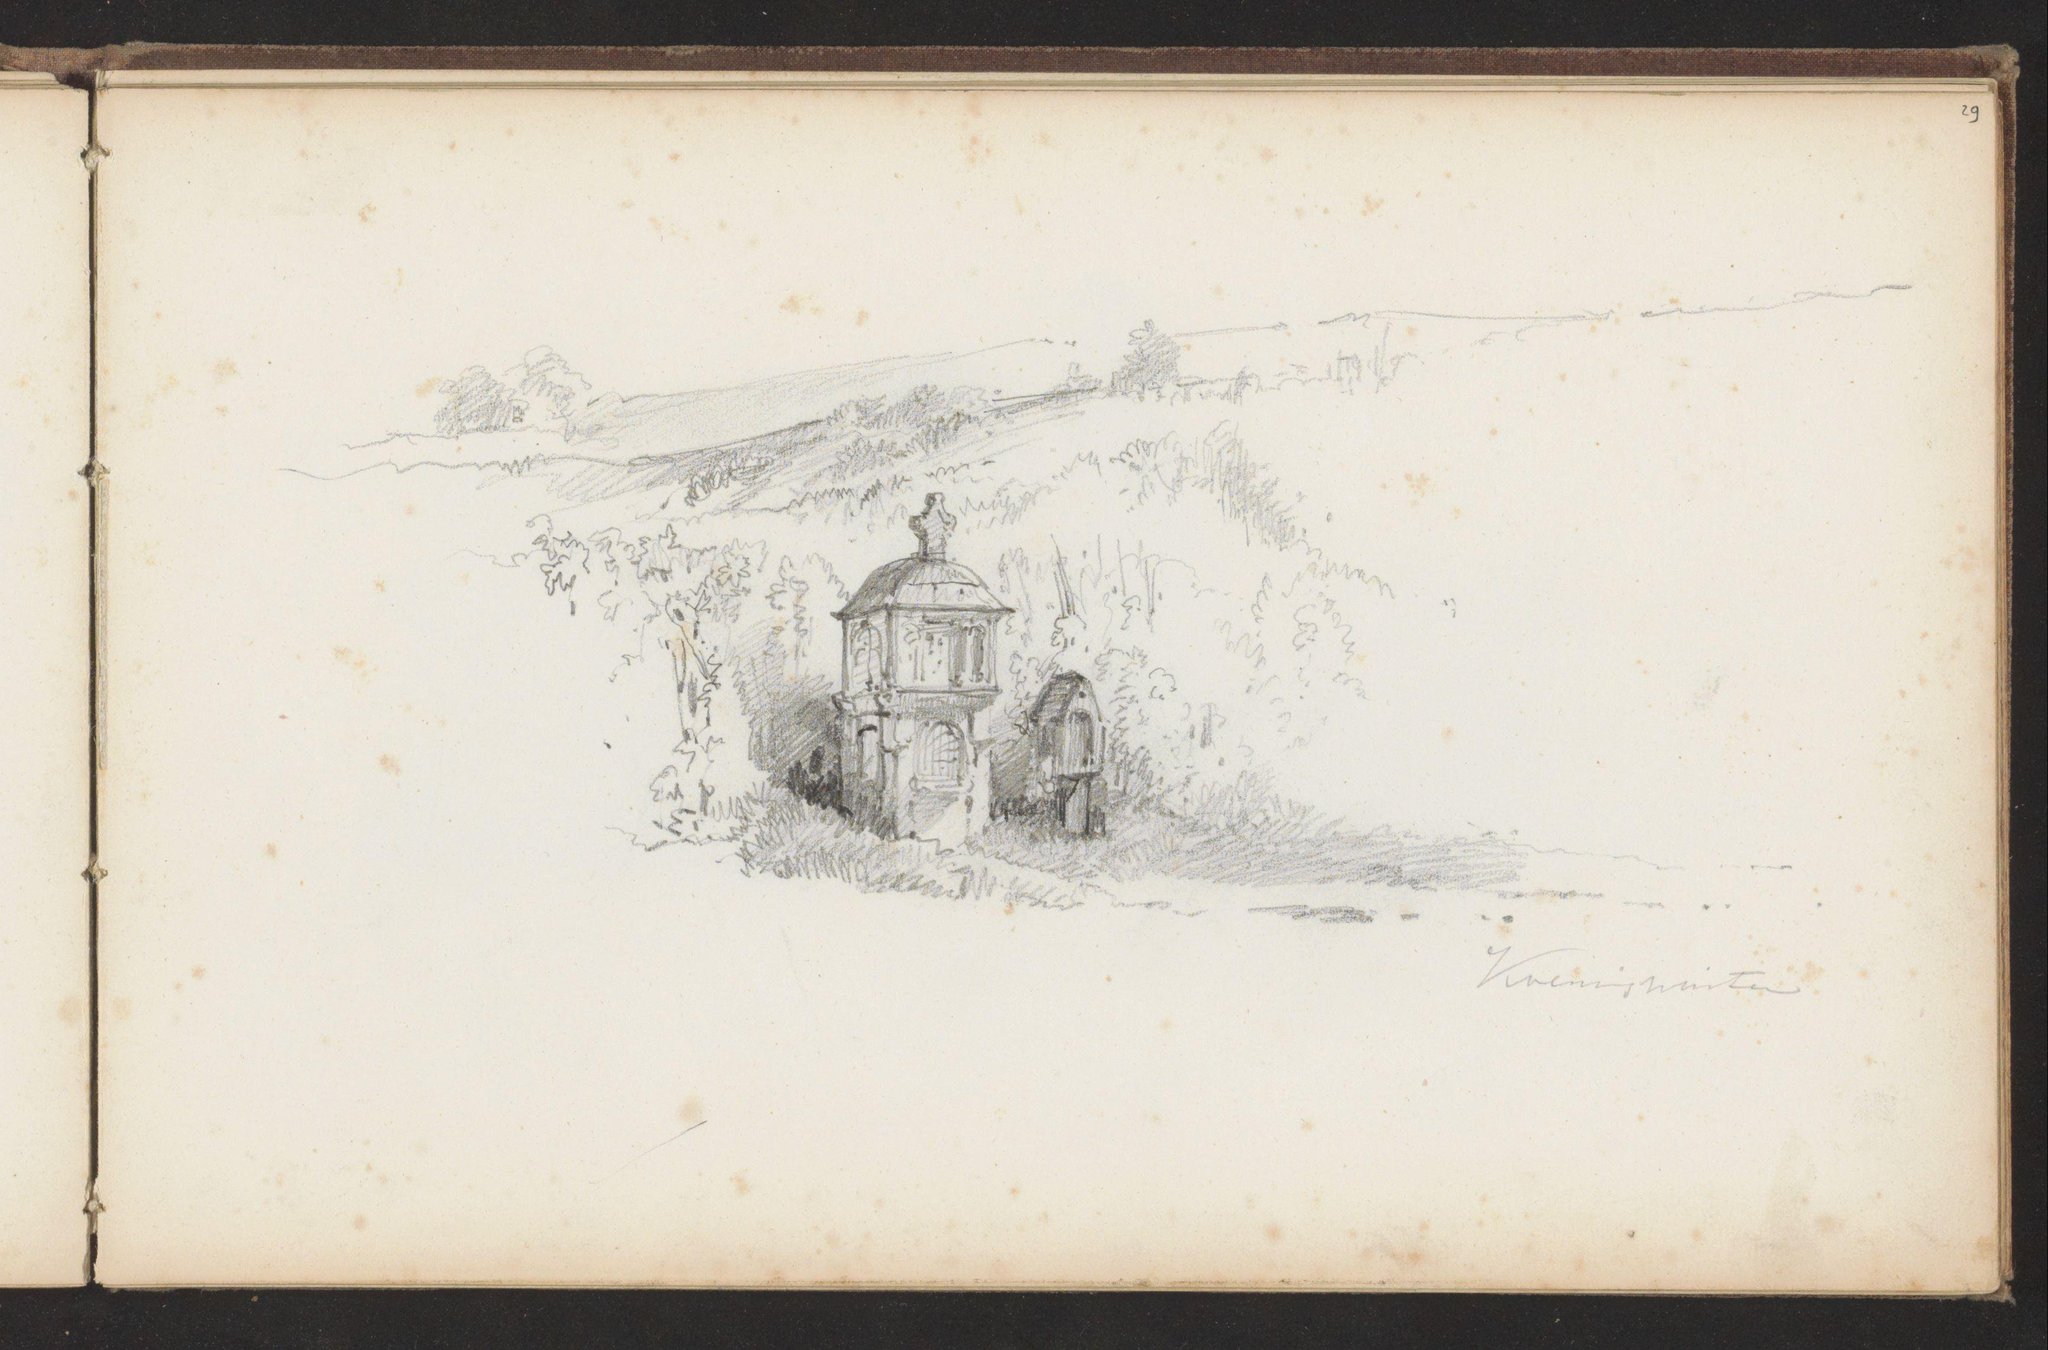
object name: sketchbook leaf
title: Kapel in een landschap bij Königswinter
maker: maria vos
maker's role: draughtsman, painter, print maker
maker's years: 1824-1906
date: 1860-1865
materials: paper, pencil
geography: königswinter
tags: city-view, and landscape with man-made constructions, church (exterior) - qq - small church, chapel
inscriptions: annotation: ‘Koenigswinter’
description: Blad 29 recto uit een schetsboek met 55 bladen.